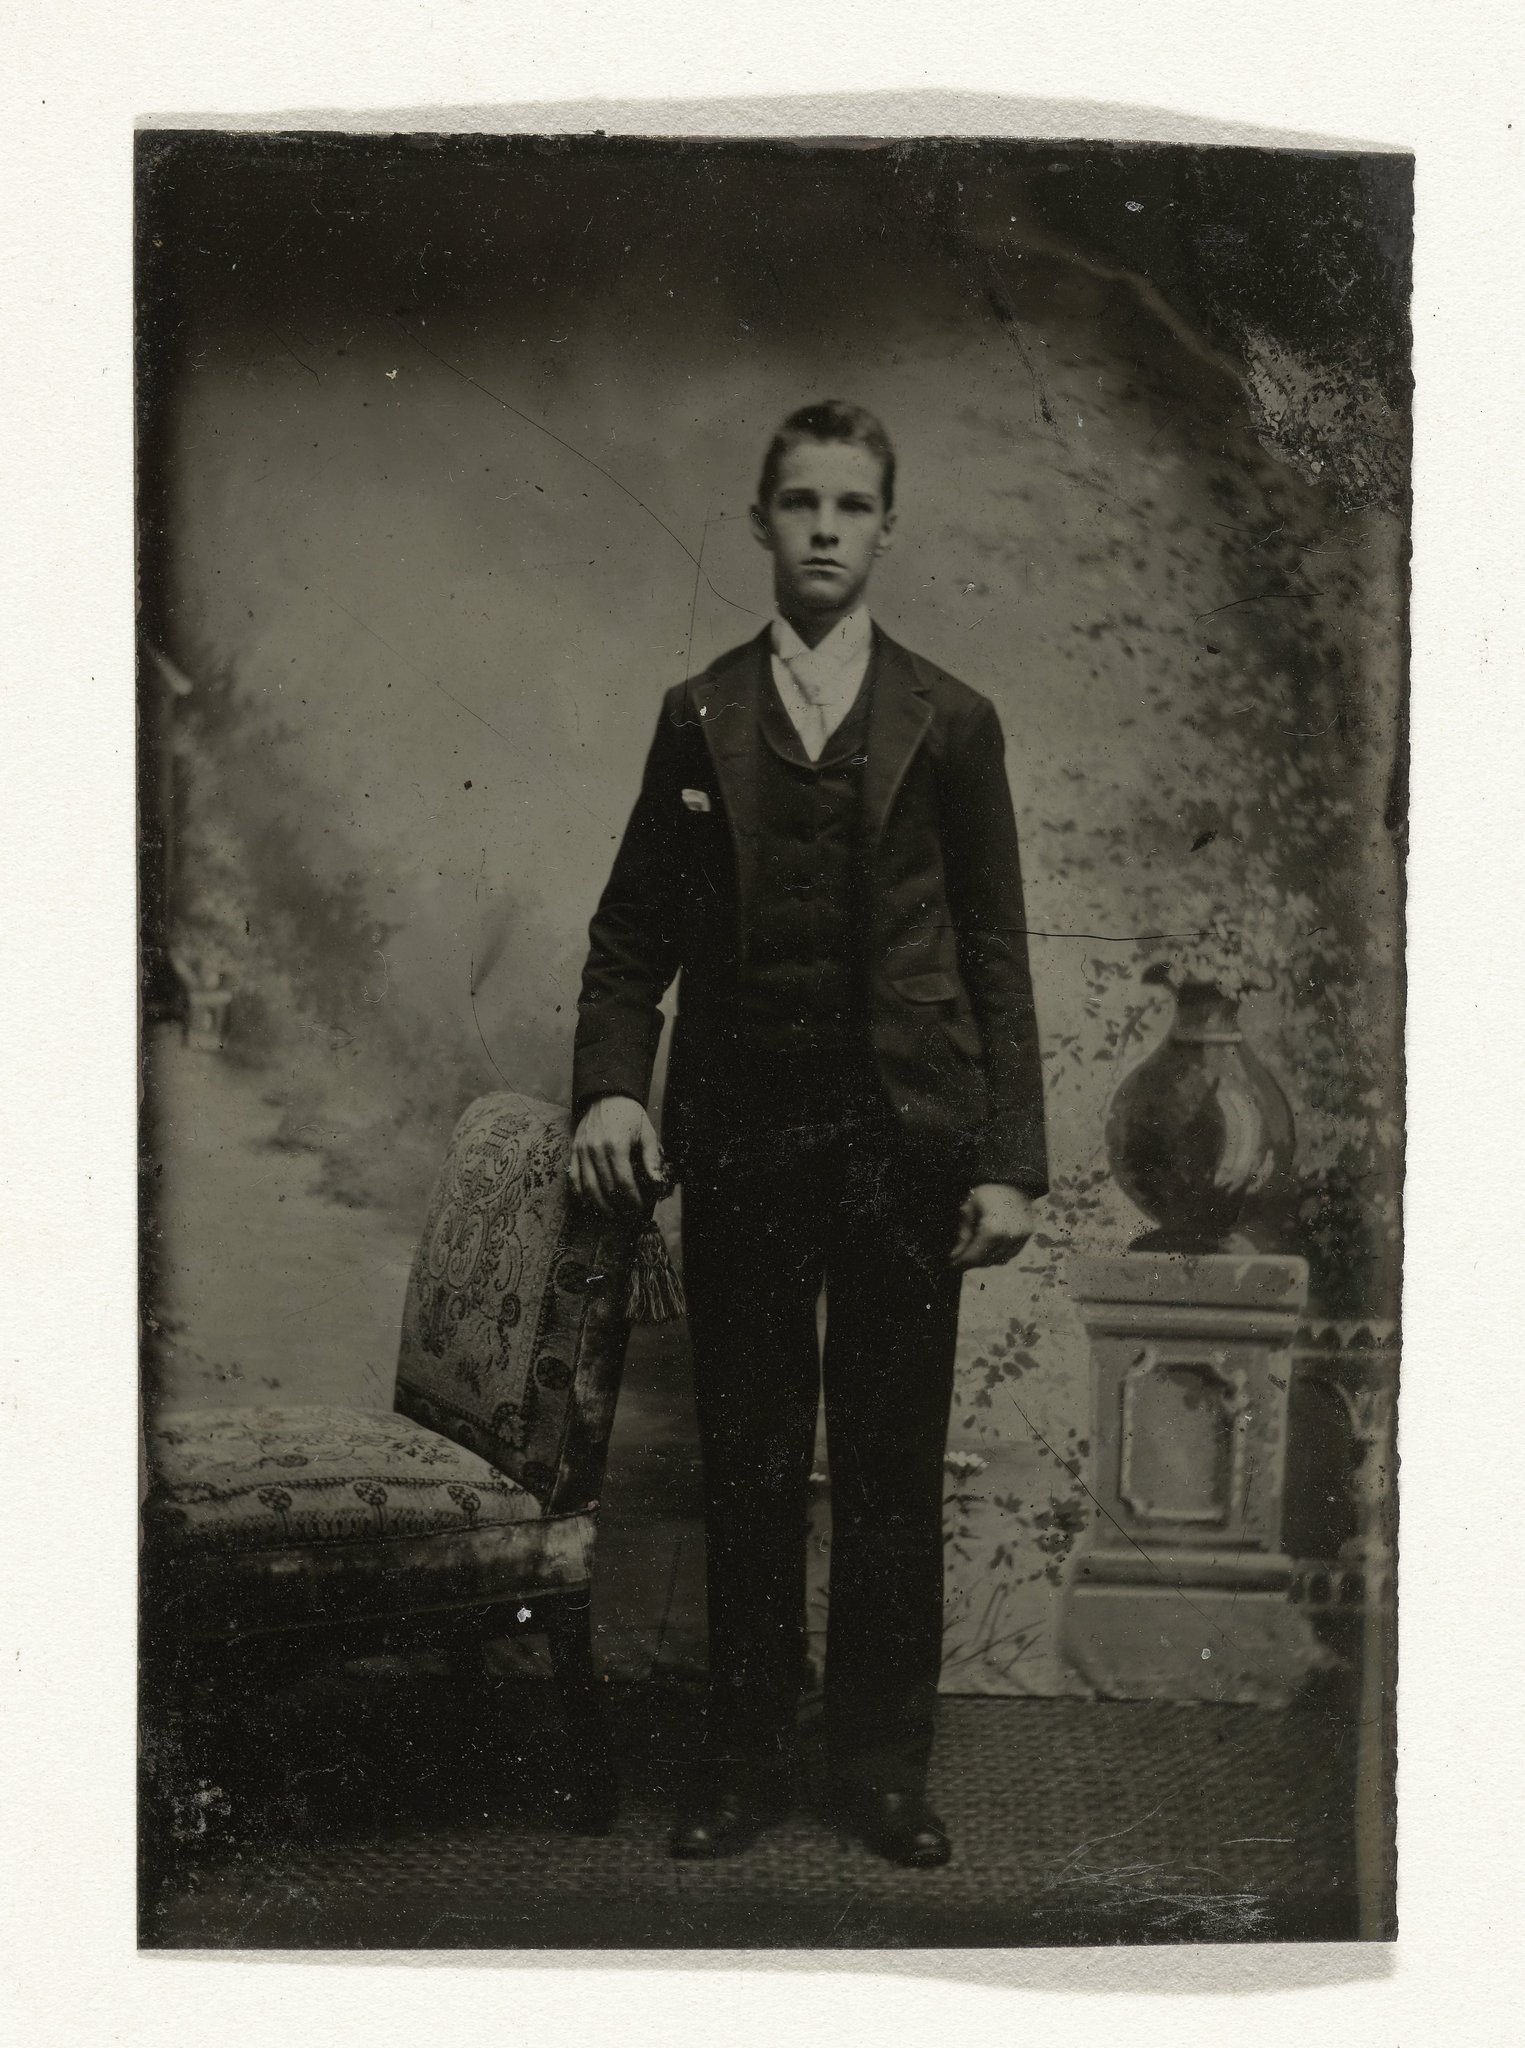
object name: photograph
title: Portret van een jongeman, staand voor een geschilderd achtergronddoek (balustrade met vaas)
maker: Anonymous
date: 1880-1900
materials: metal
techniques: ferrotyping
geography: united states